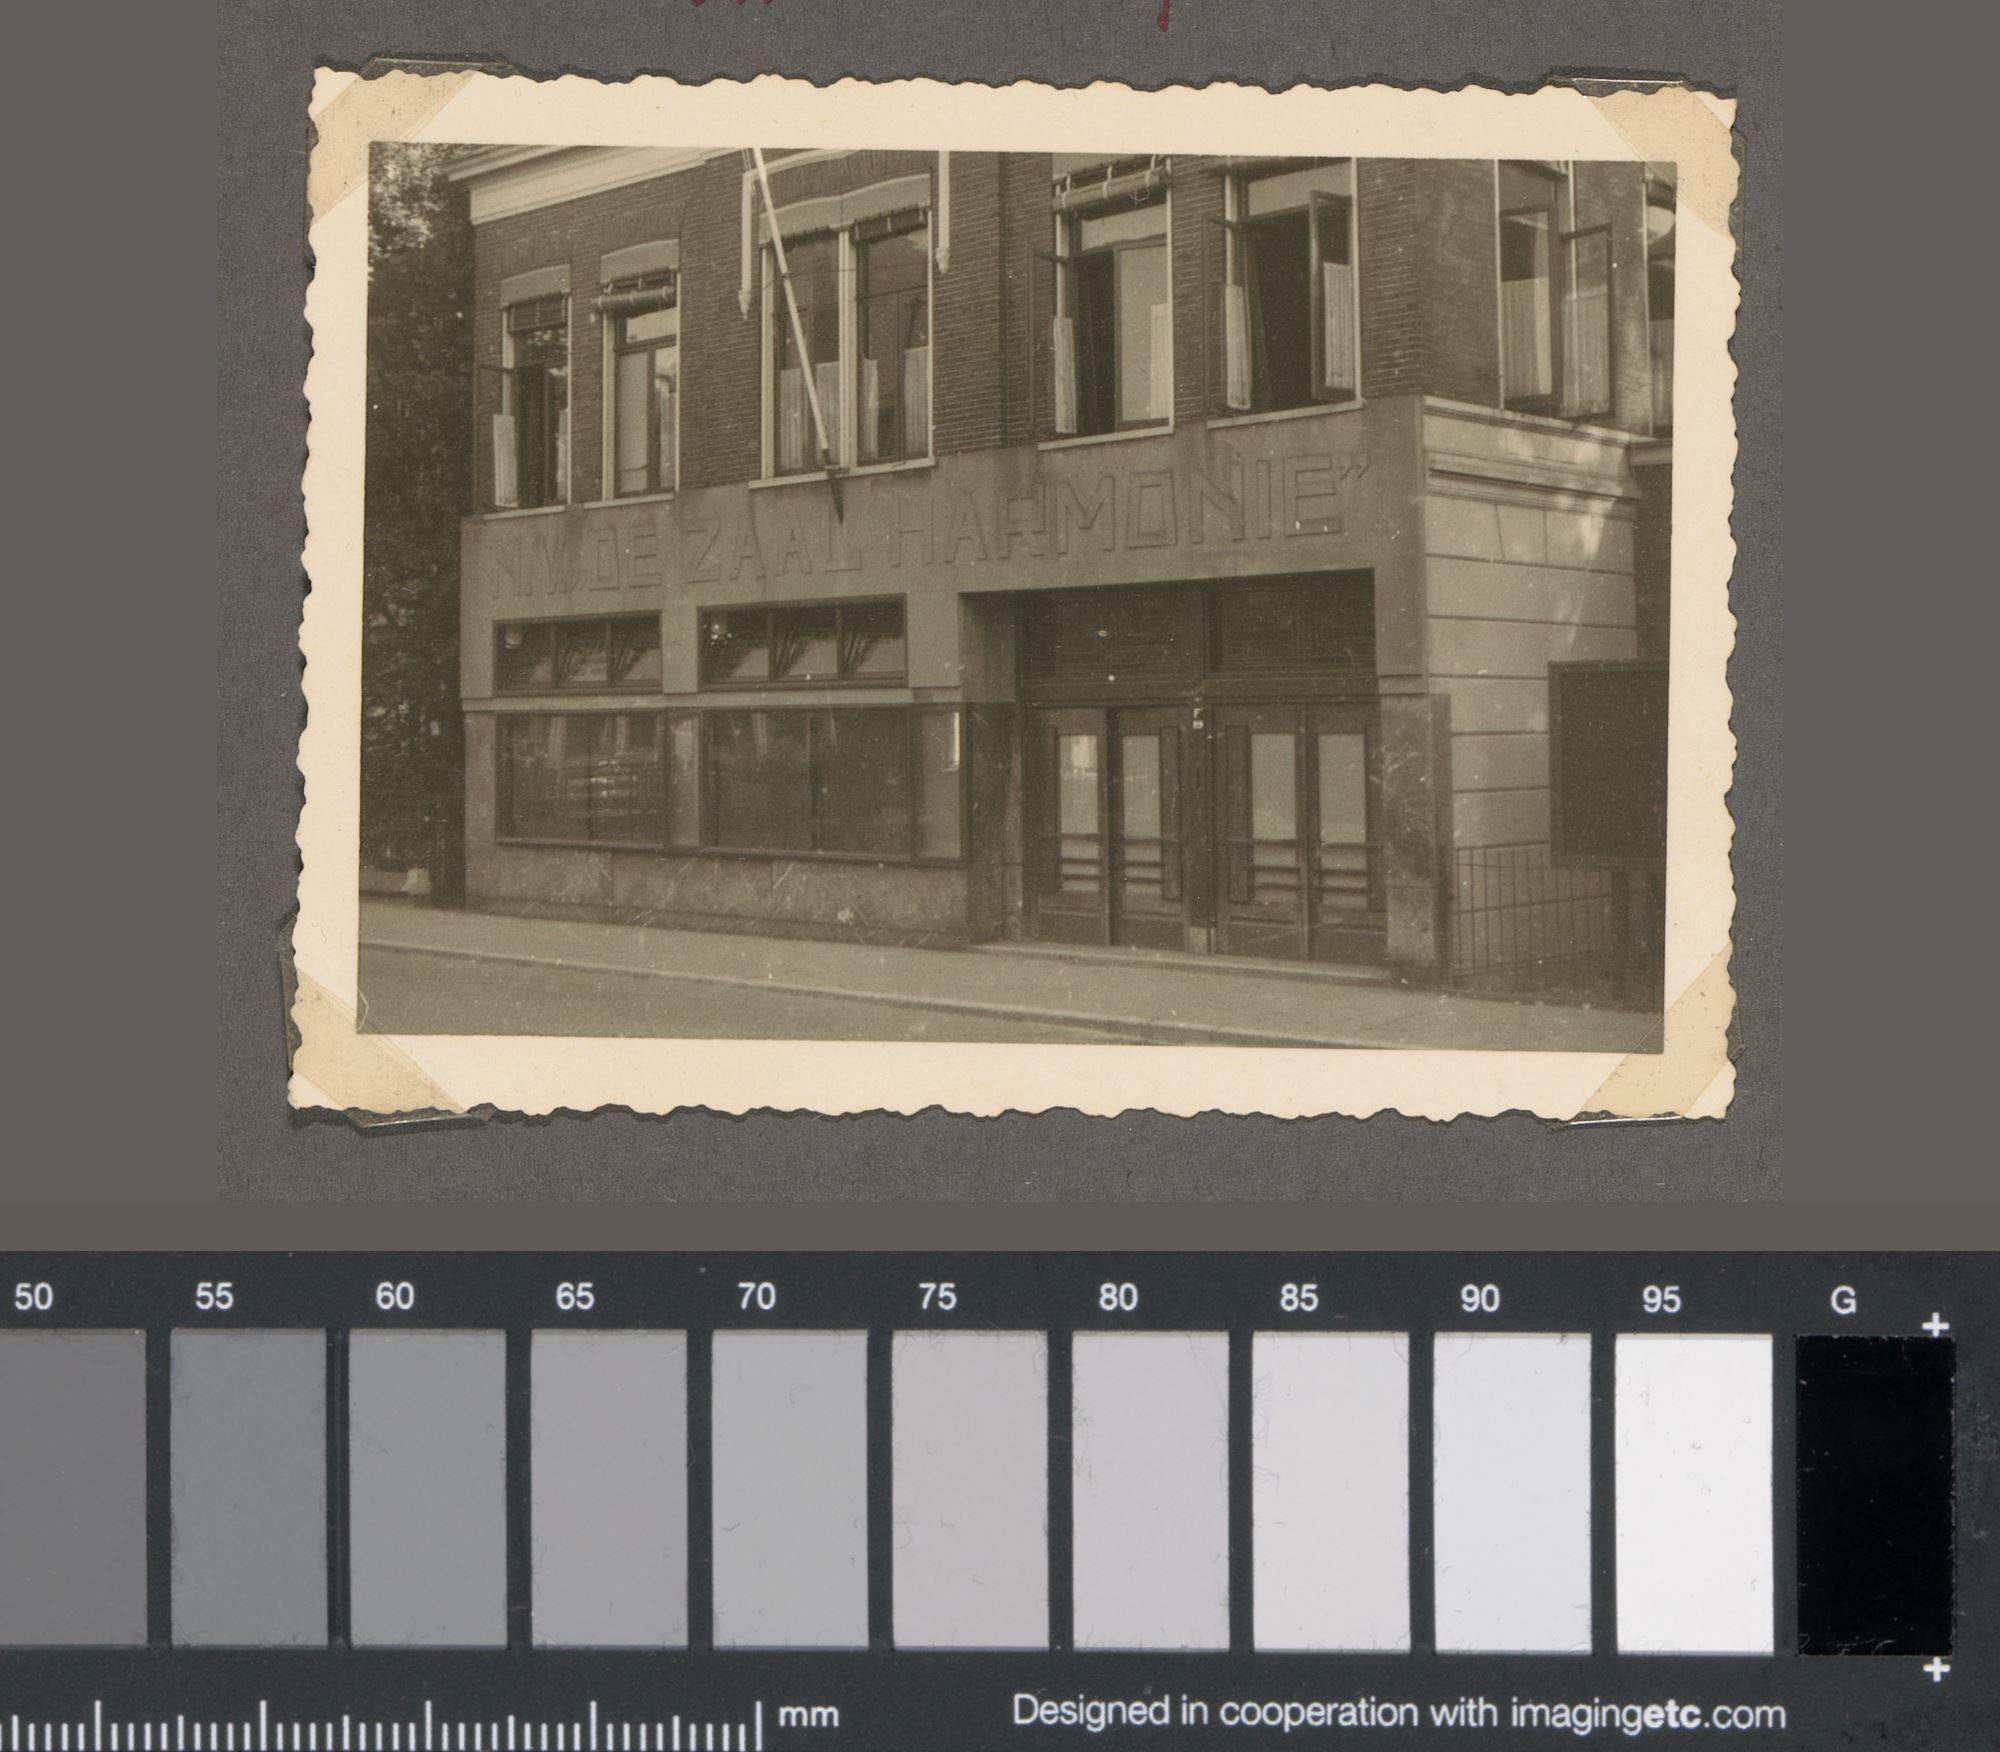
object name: photograph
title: Unterkunft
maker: Anonymous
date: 1941-1945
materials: paper, photographic support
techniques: gelatin silver print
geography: vlaardingen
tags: civic architecture; edifices; dwellings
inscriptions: annotation: ‘Vlaardingen/Rotterdam’